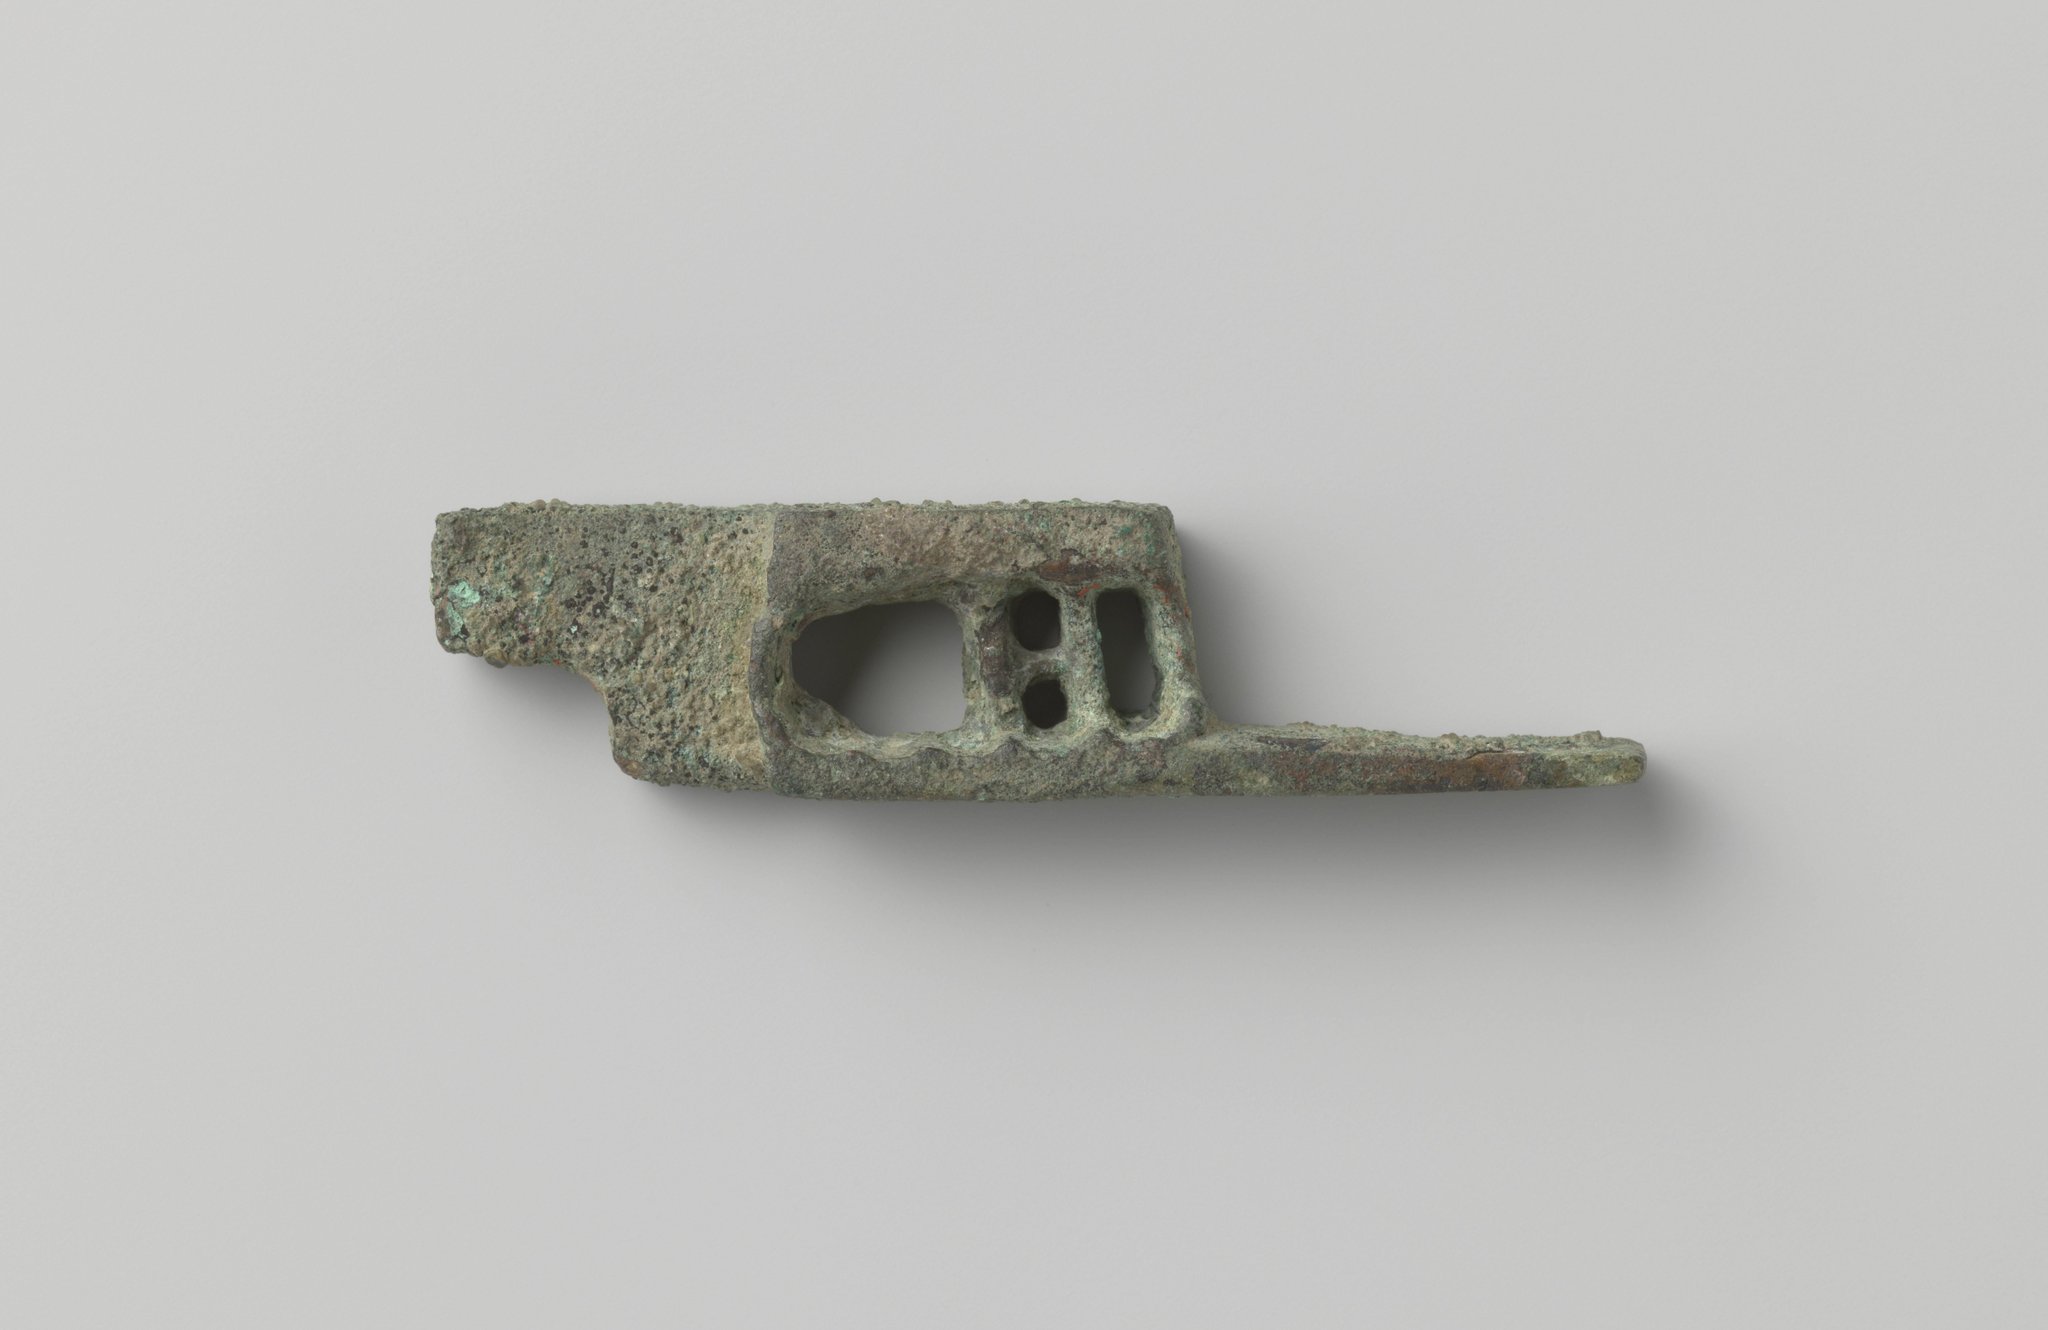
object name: lock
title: Fragment van schot en slot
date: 1400-1950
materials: bronze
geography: rome